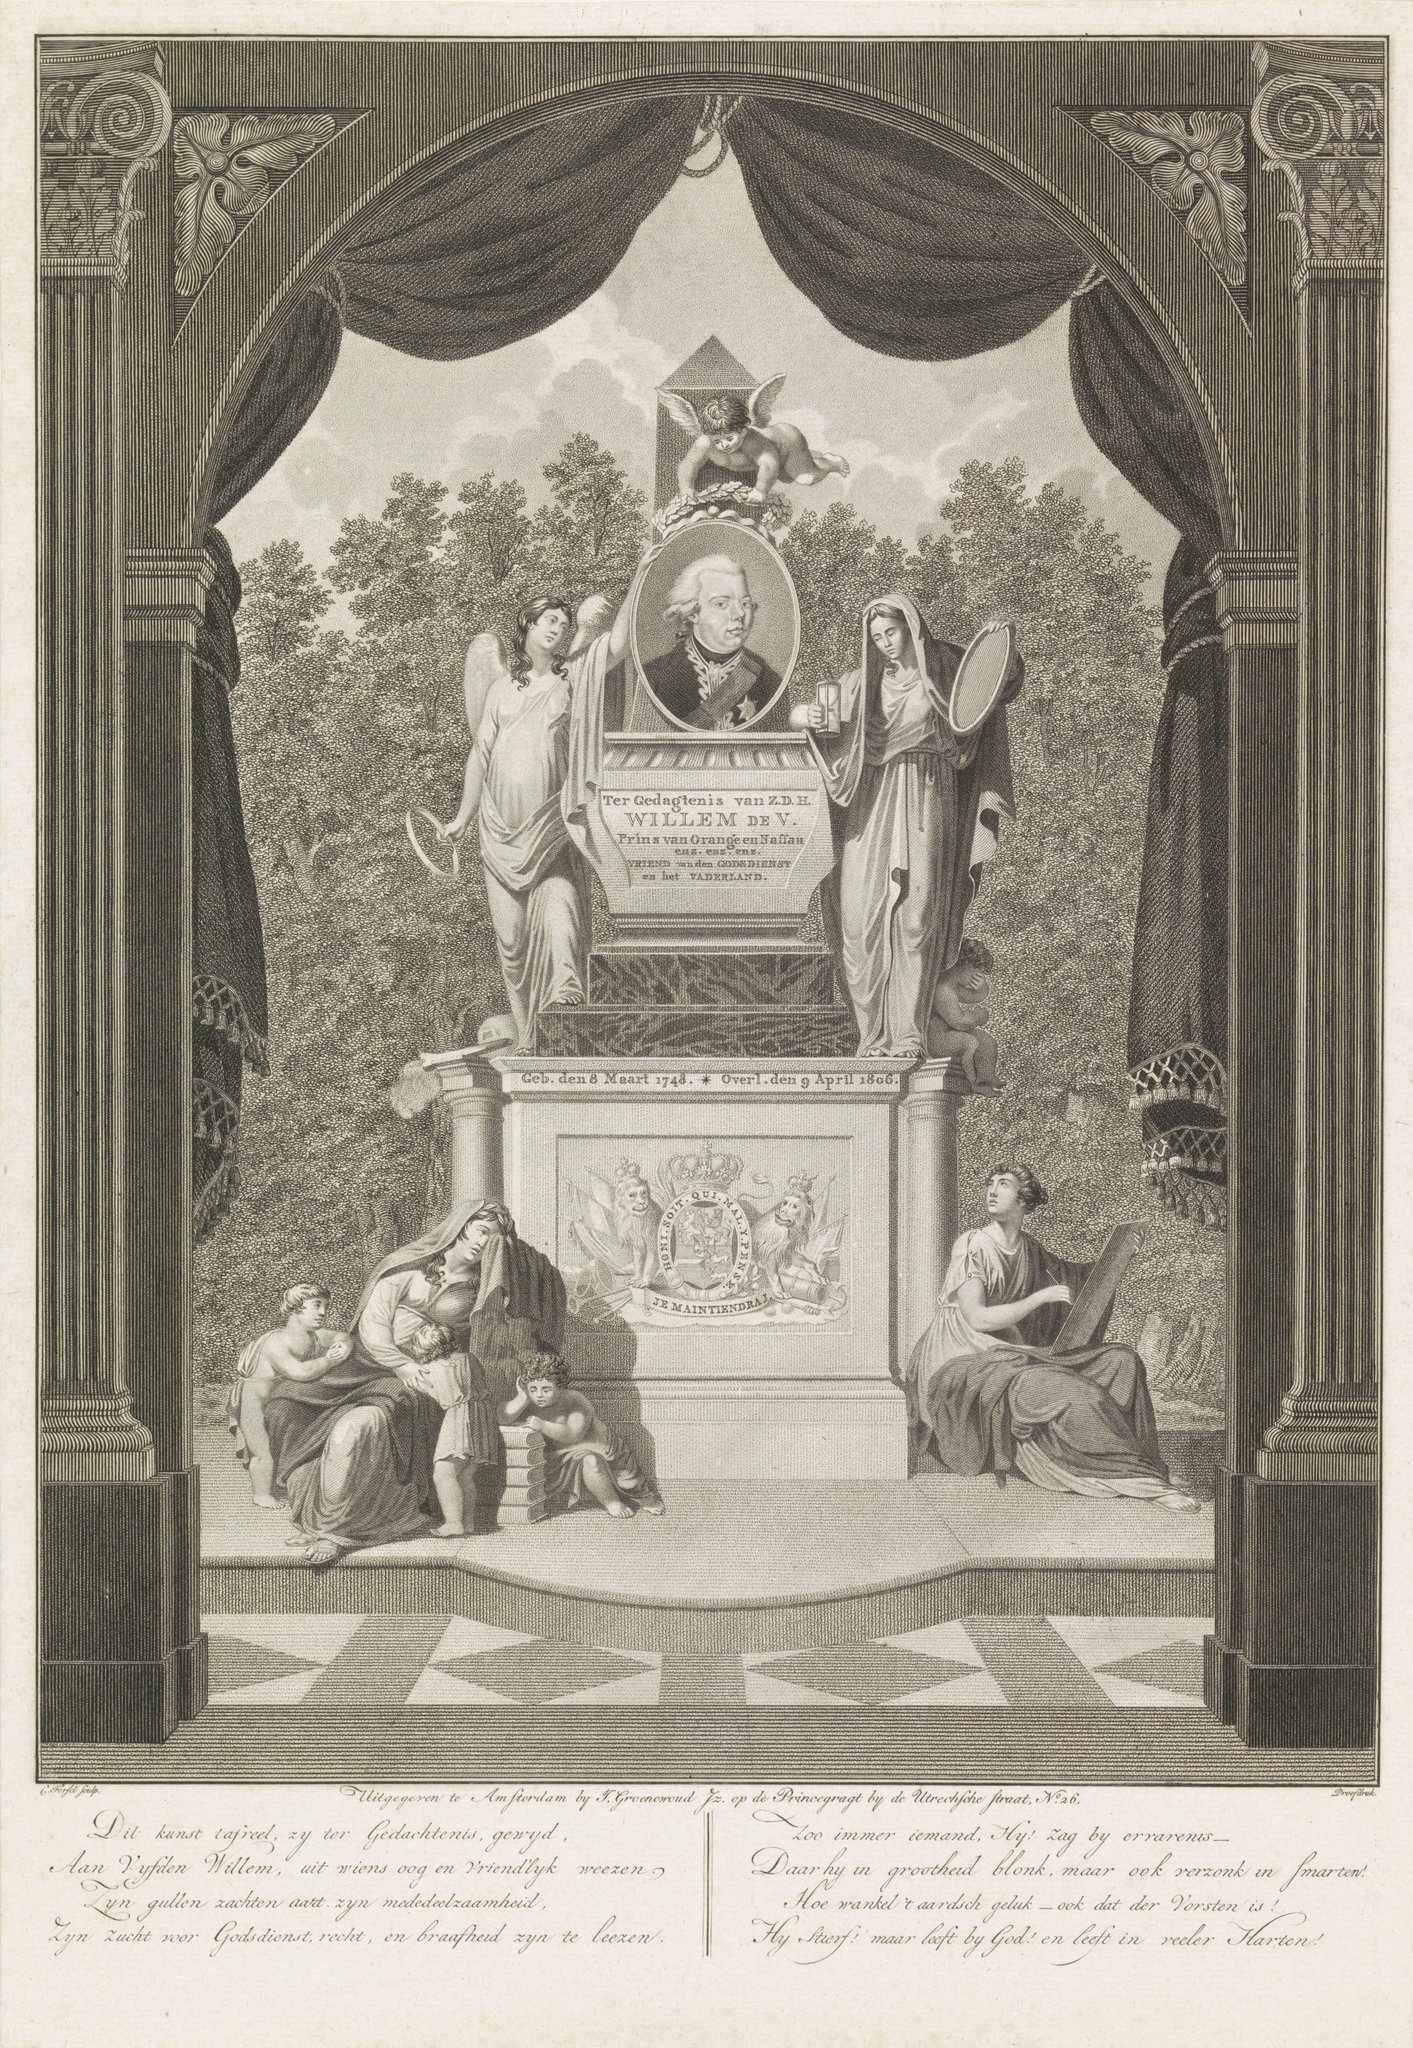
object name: print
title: Allegorisch grafmonument voor prins Willem V, 1806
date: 1806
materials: paper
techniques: etching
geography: amsterdam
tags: the hague, william v (prince of orange), eternity, 'aeternitas'; 'eternità','eternità o perpetuità' (ripa), 'historia'; 'historia' (ripa), grave-building, monumental tomb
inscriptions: collector's mark: Lugt 2228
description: Gezicht door een poort met gordijnen op het allegorische grafmonument voor prins Willem V, overleden op 9 april 1806. Aan weerszijden van de tombe met portret van de prins de staande figuren van Waarheid en Standvastigheid (rechts) en Onsterfelijkheid (links). Zittend aan de basis van het monument rechts de schrijvende Historie, links een moeder met drie kinderen. In het onderschrift een achtregelig vers. Bij de prent behoort een gedrukt bericht van intekening en een aankondiging. Zie ook de later vervaardigde pendant.